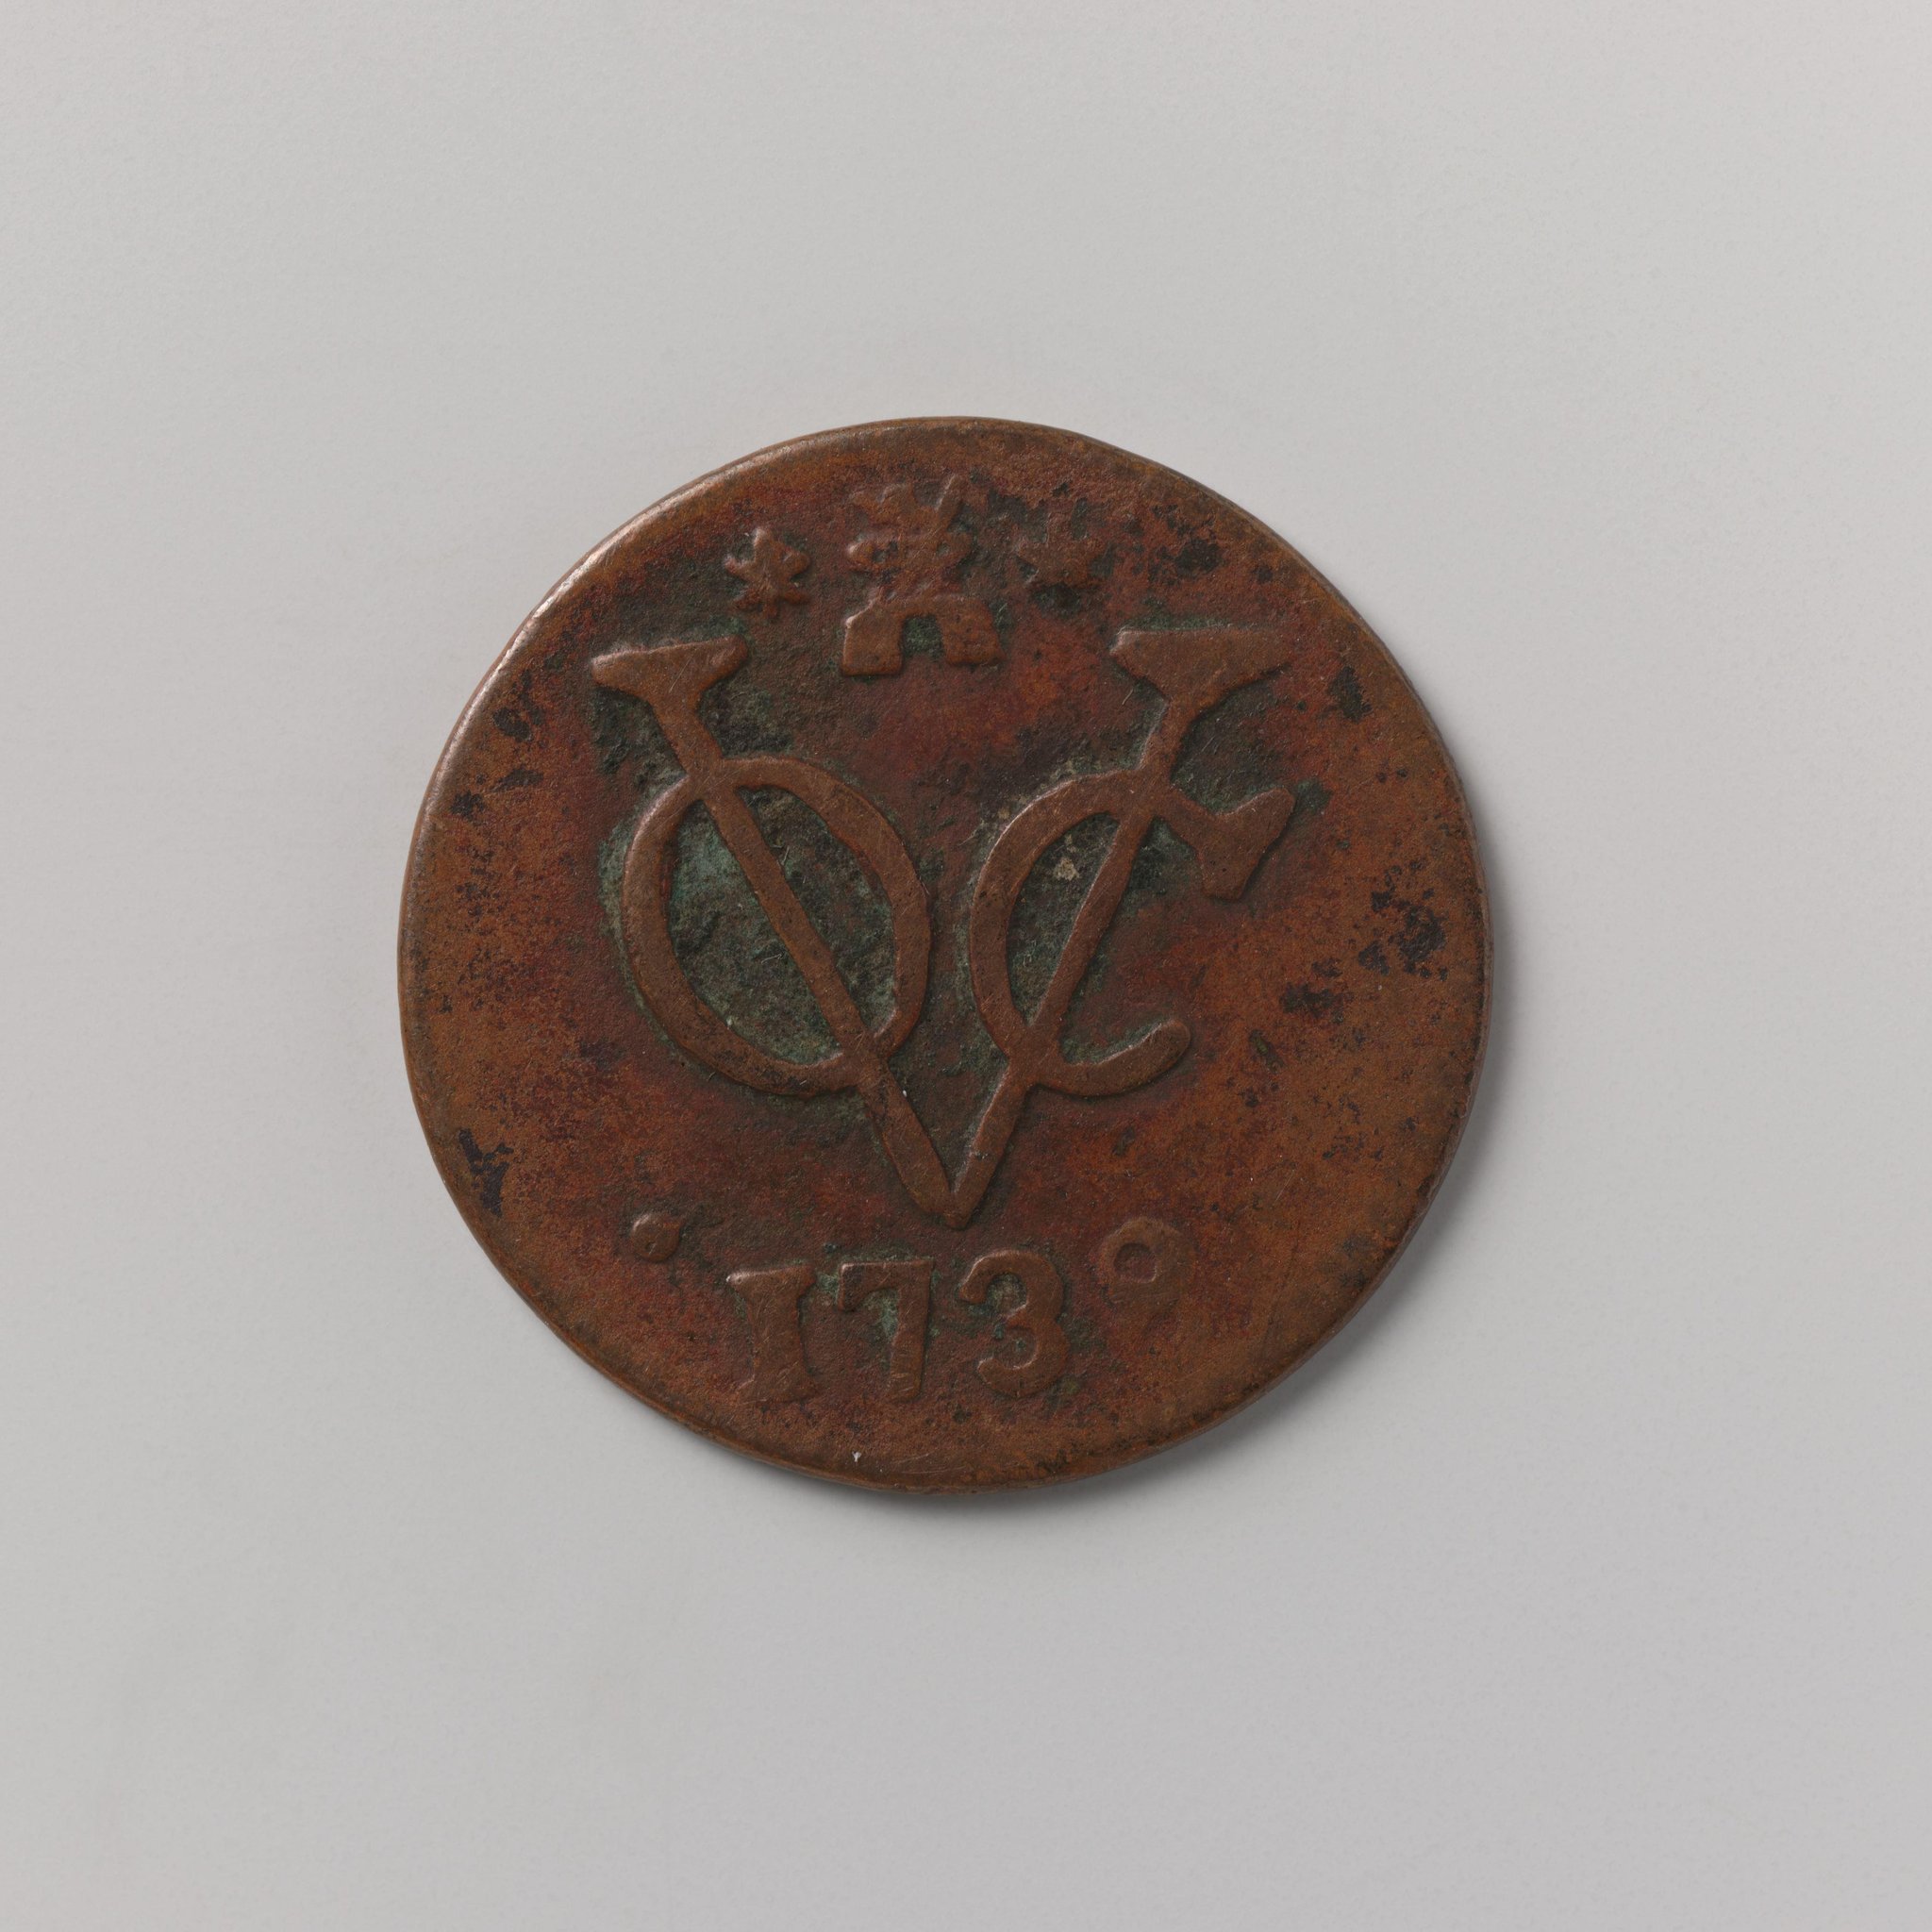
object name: coin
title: VOC, duit Zeeland, 1738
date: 1738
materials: copper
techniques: striking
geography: middelburg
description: Koperen munt. Voorzijde: gekroond wapenschild van Zeeland. Keerzijde: monogram van de VOC, waarboven muntteken en waaronder jaartal. Gladde rand.